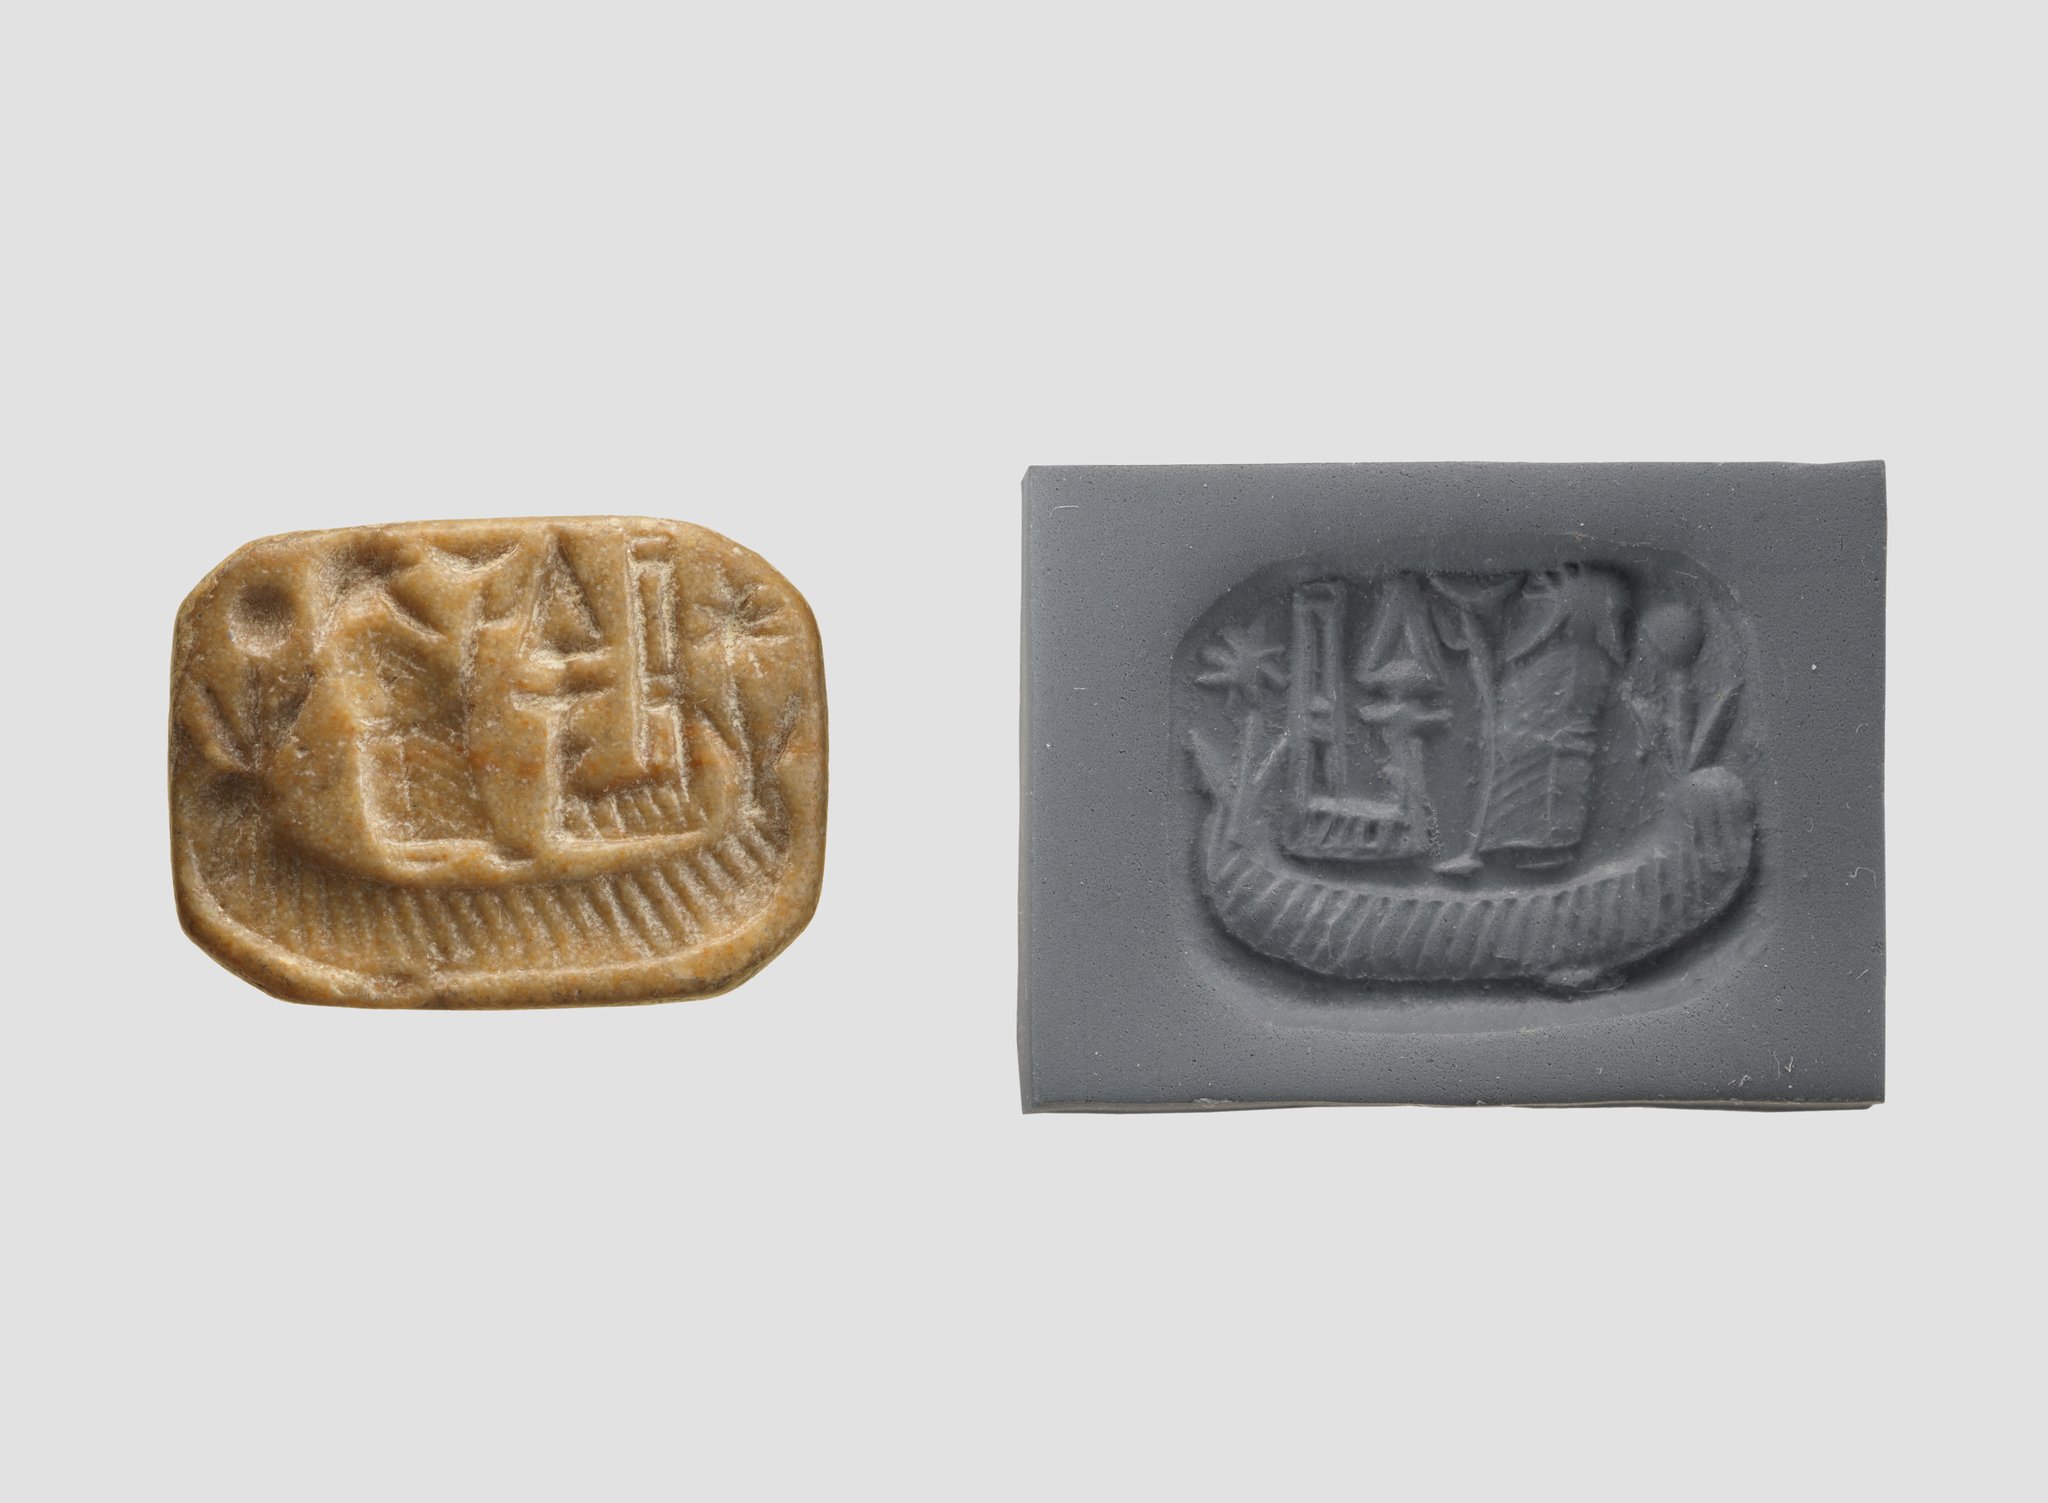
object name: stamp seal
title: Stamp seal (octagonal pyramid) with cultic scene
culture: assyrian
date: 734-601 BCE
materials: limestone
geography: mesopotamia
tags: men